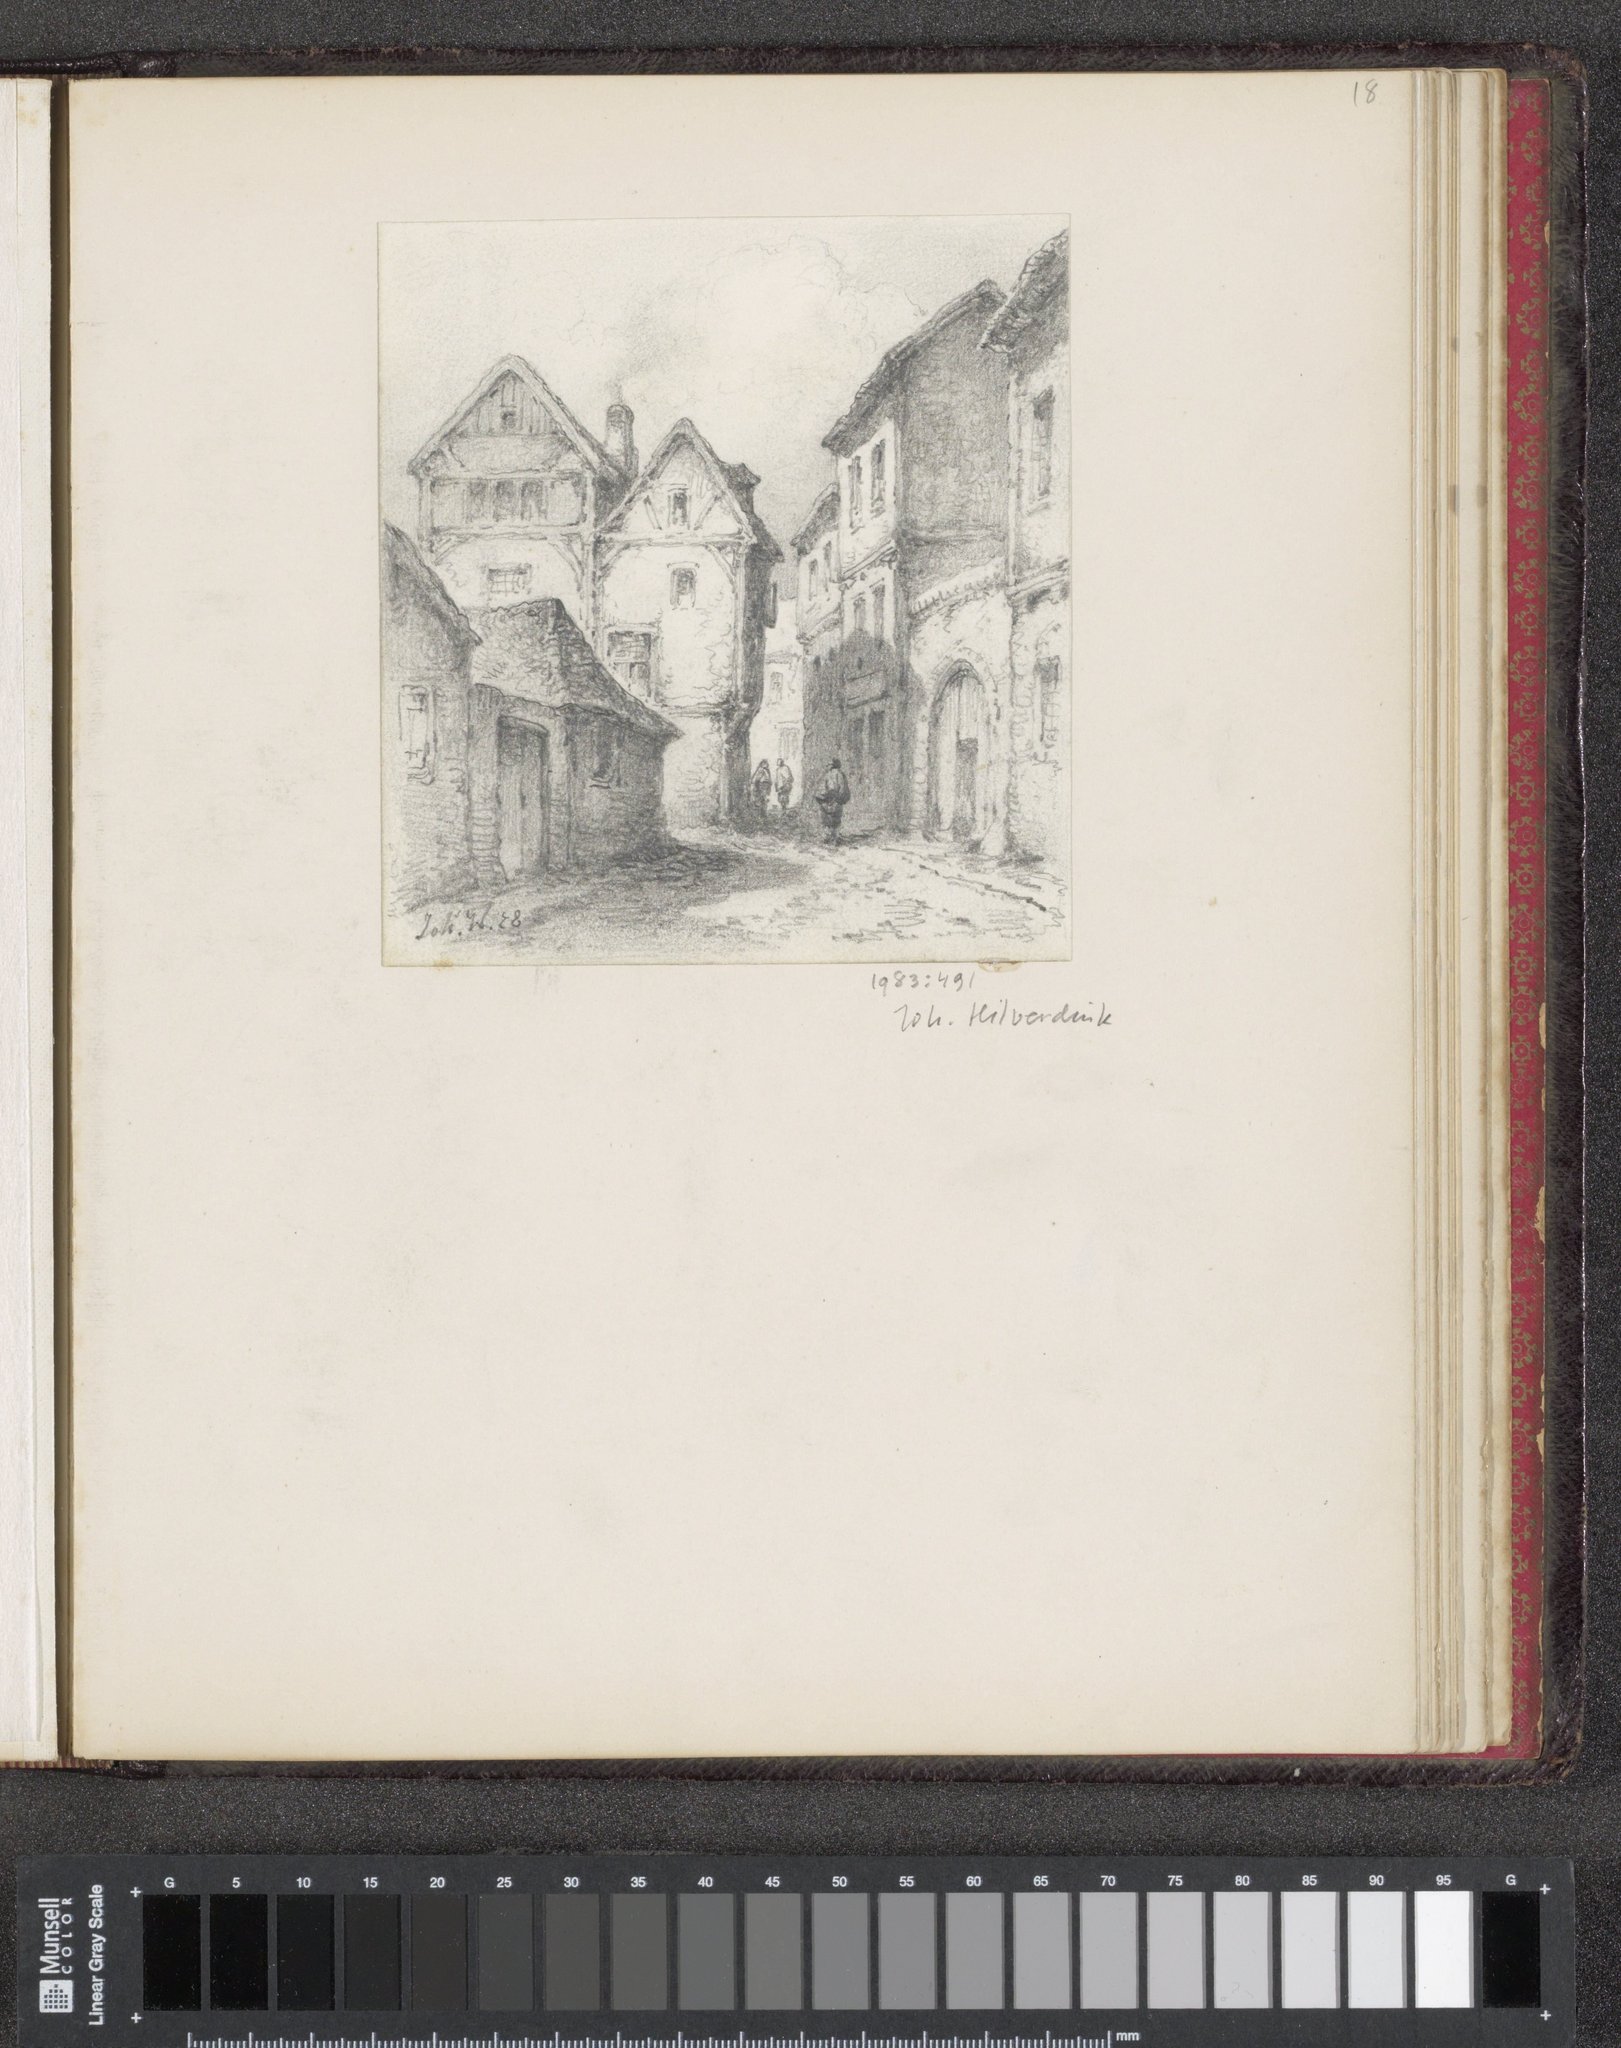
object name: album leaf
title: Drie figuren op een straat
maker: johannes hilverdink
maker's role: draughtsman, painter, print maker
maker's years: 1813-1902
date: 1878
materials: paper, pencil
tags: village street (+ city(-scape) with figures, staffage)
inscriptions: signature and date: ‘Joh. H. 78’